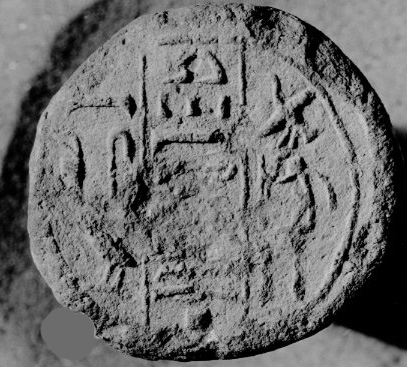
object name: cone, circular impression, paser, child, nursery, bowman, follower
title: Funerary Cone of the Chief Bowman Paser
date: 1425-1400 BCE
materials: pottery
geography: egypt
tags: hieroglyphs